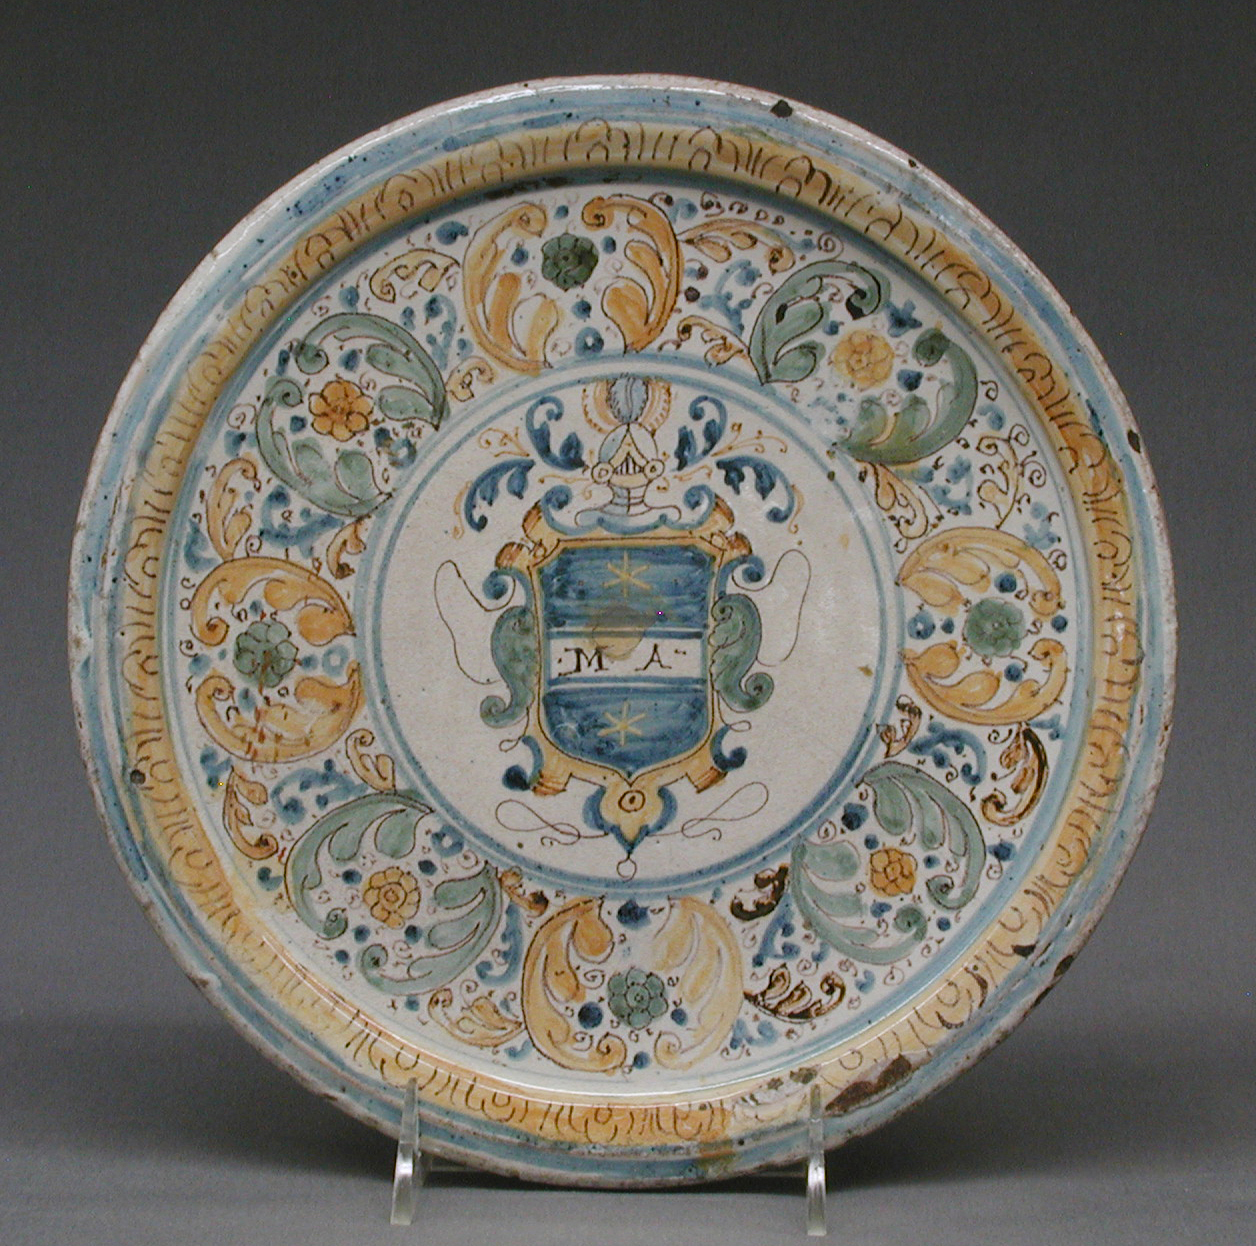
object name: tazza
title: Tazza (Alzata)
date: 1667-1700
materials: earthenware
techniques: glazing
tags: flowers,coat of arms